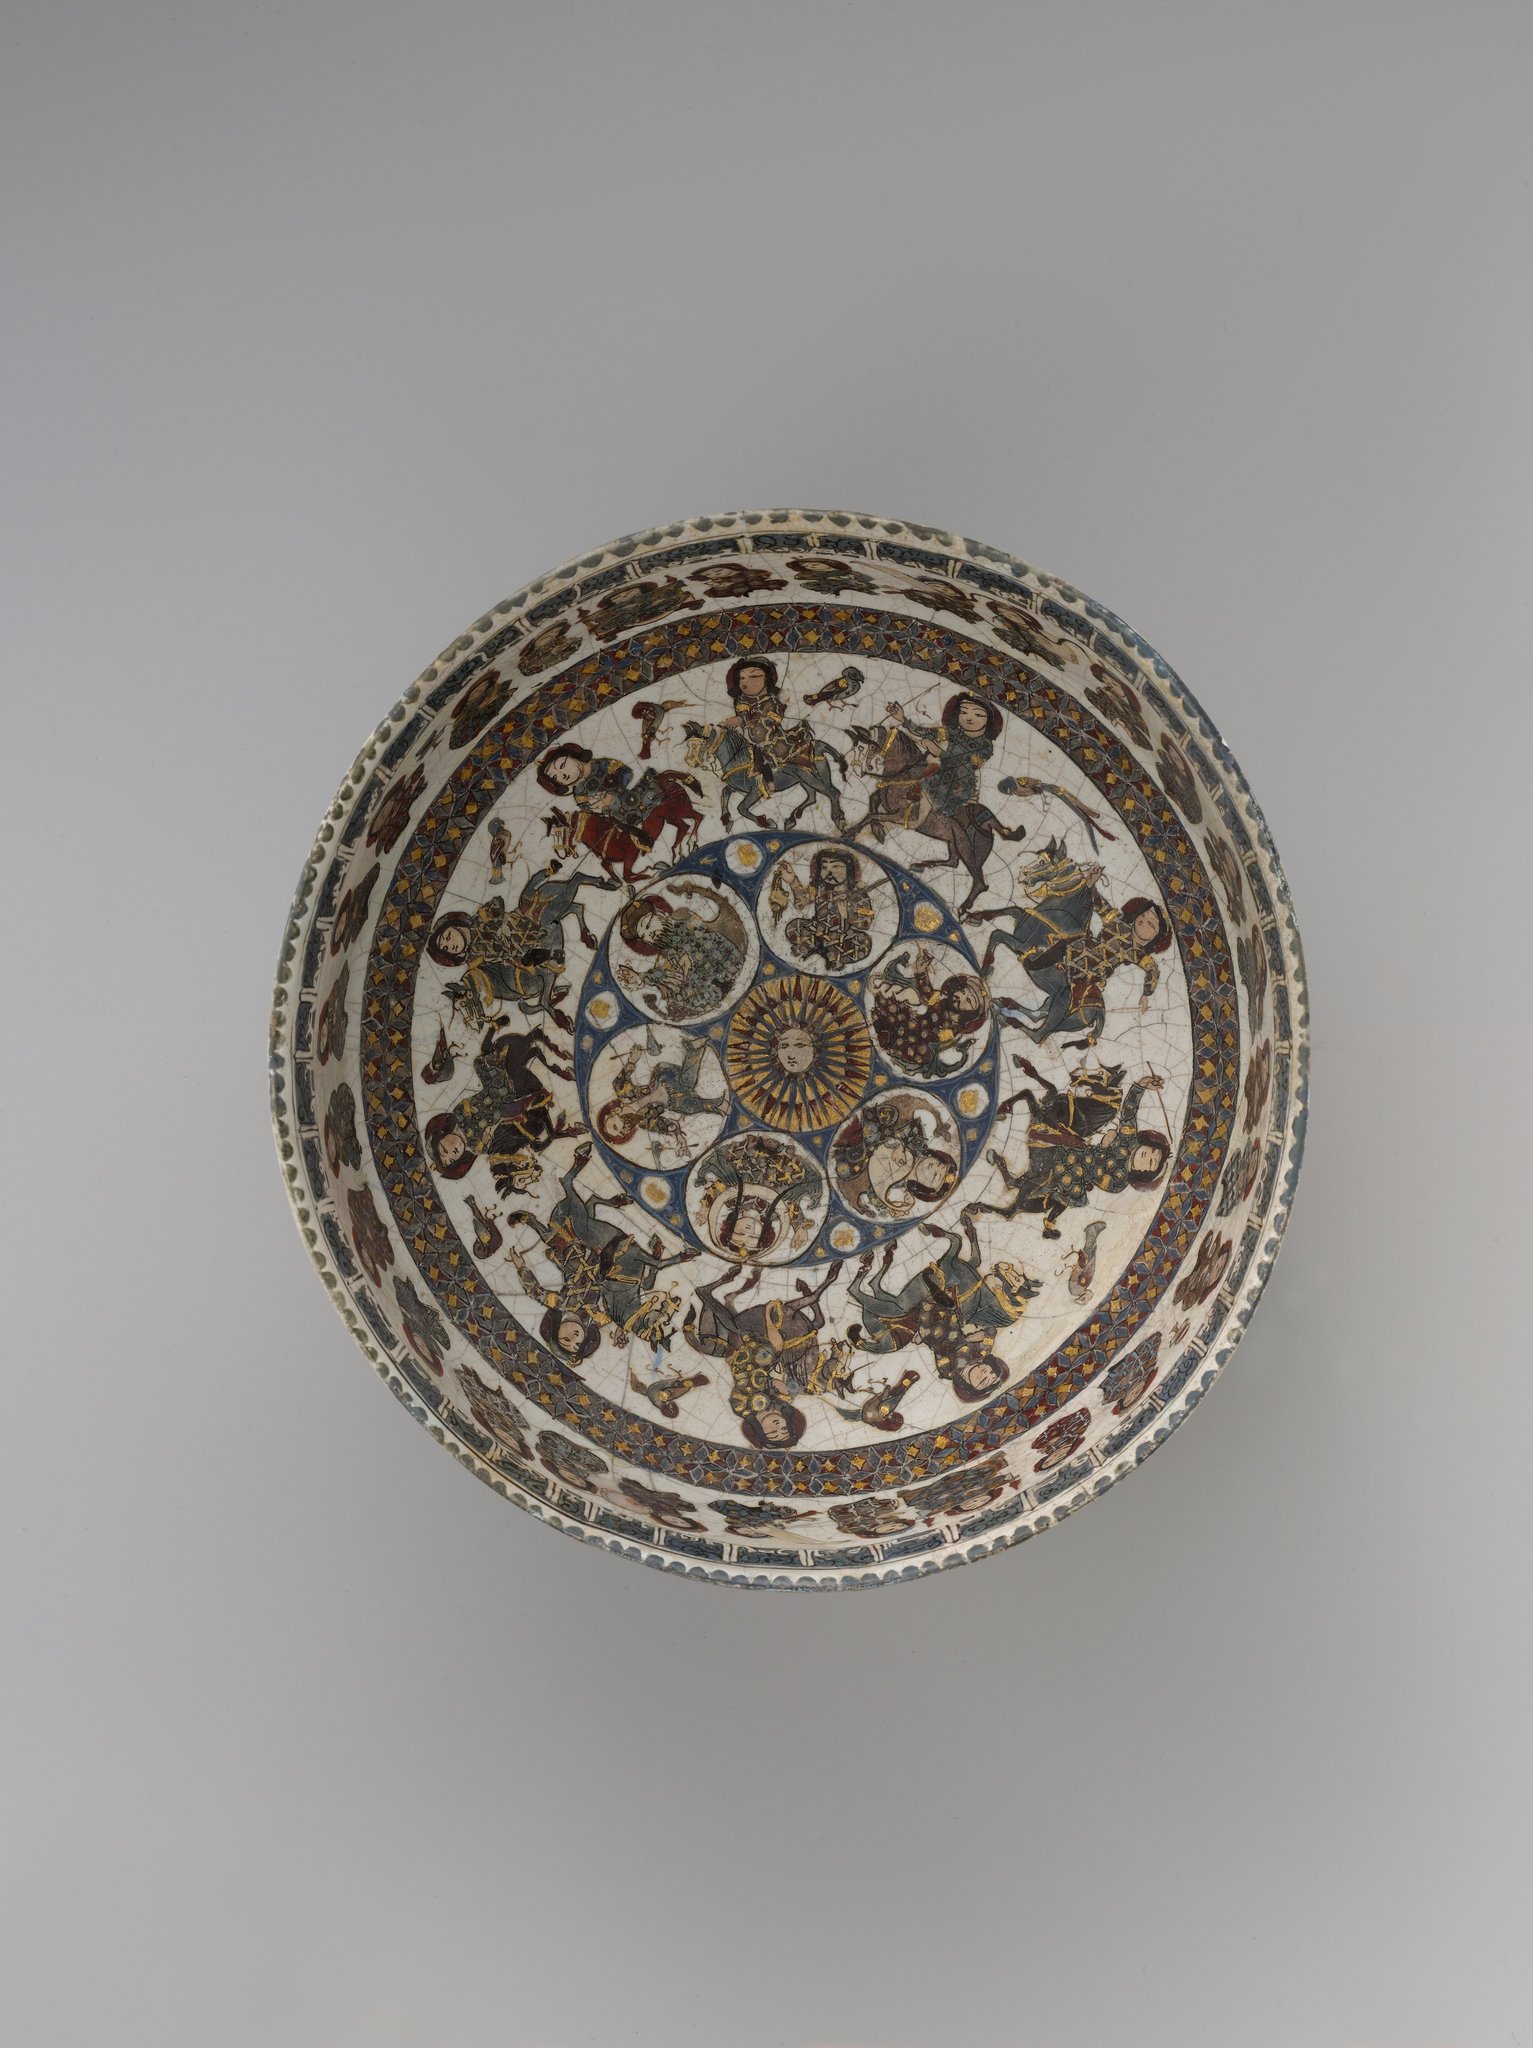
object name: bowl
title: Bowl with Courtly and Astrological Motifs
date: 1167-1233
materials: glaze, stonepaste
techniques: gilding, overglaze, painting, polychrome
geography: northern iran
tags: birds,horses,planets,sun,astronomy